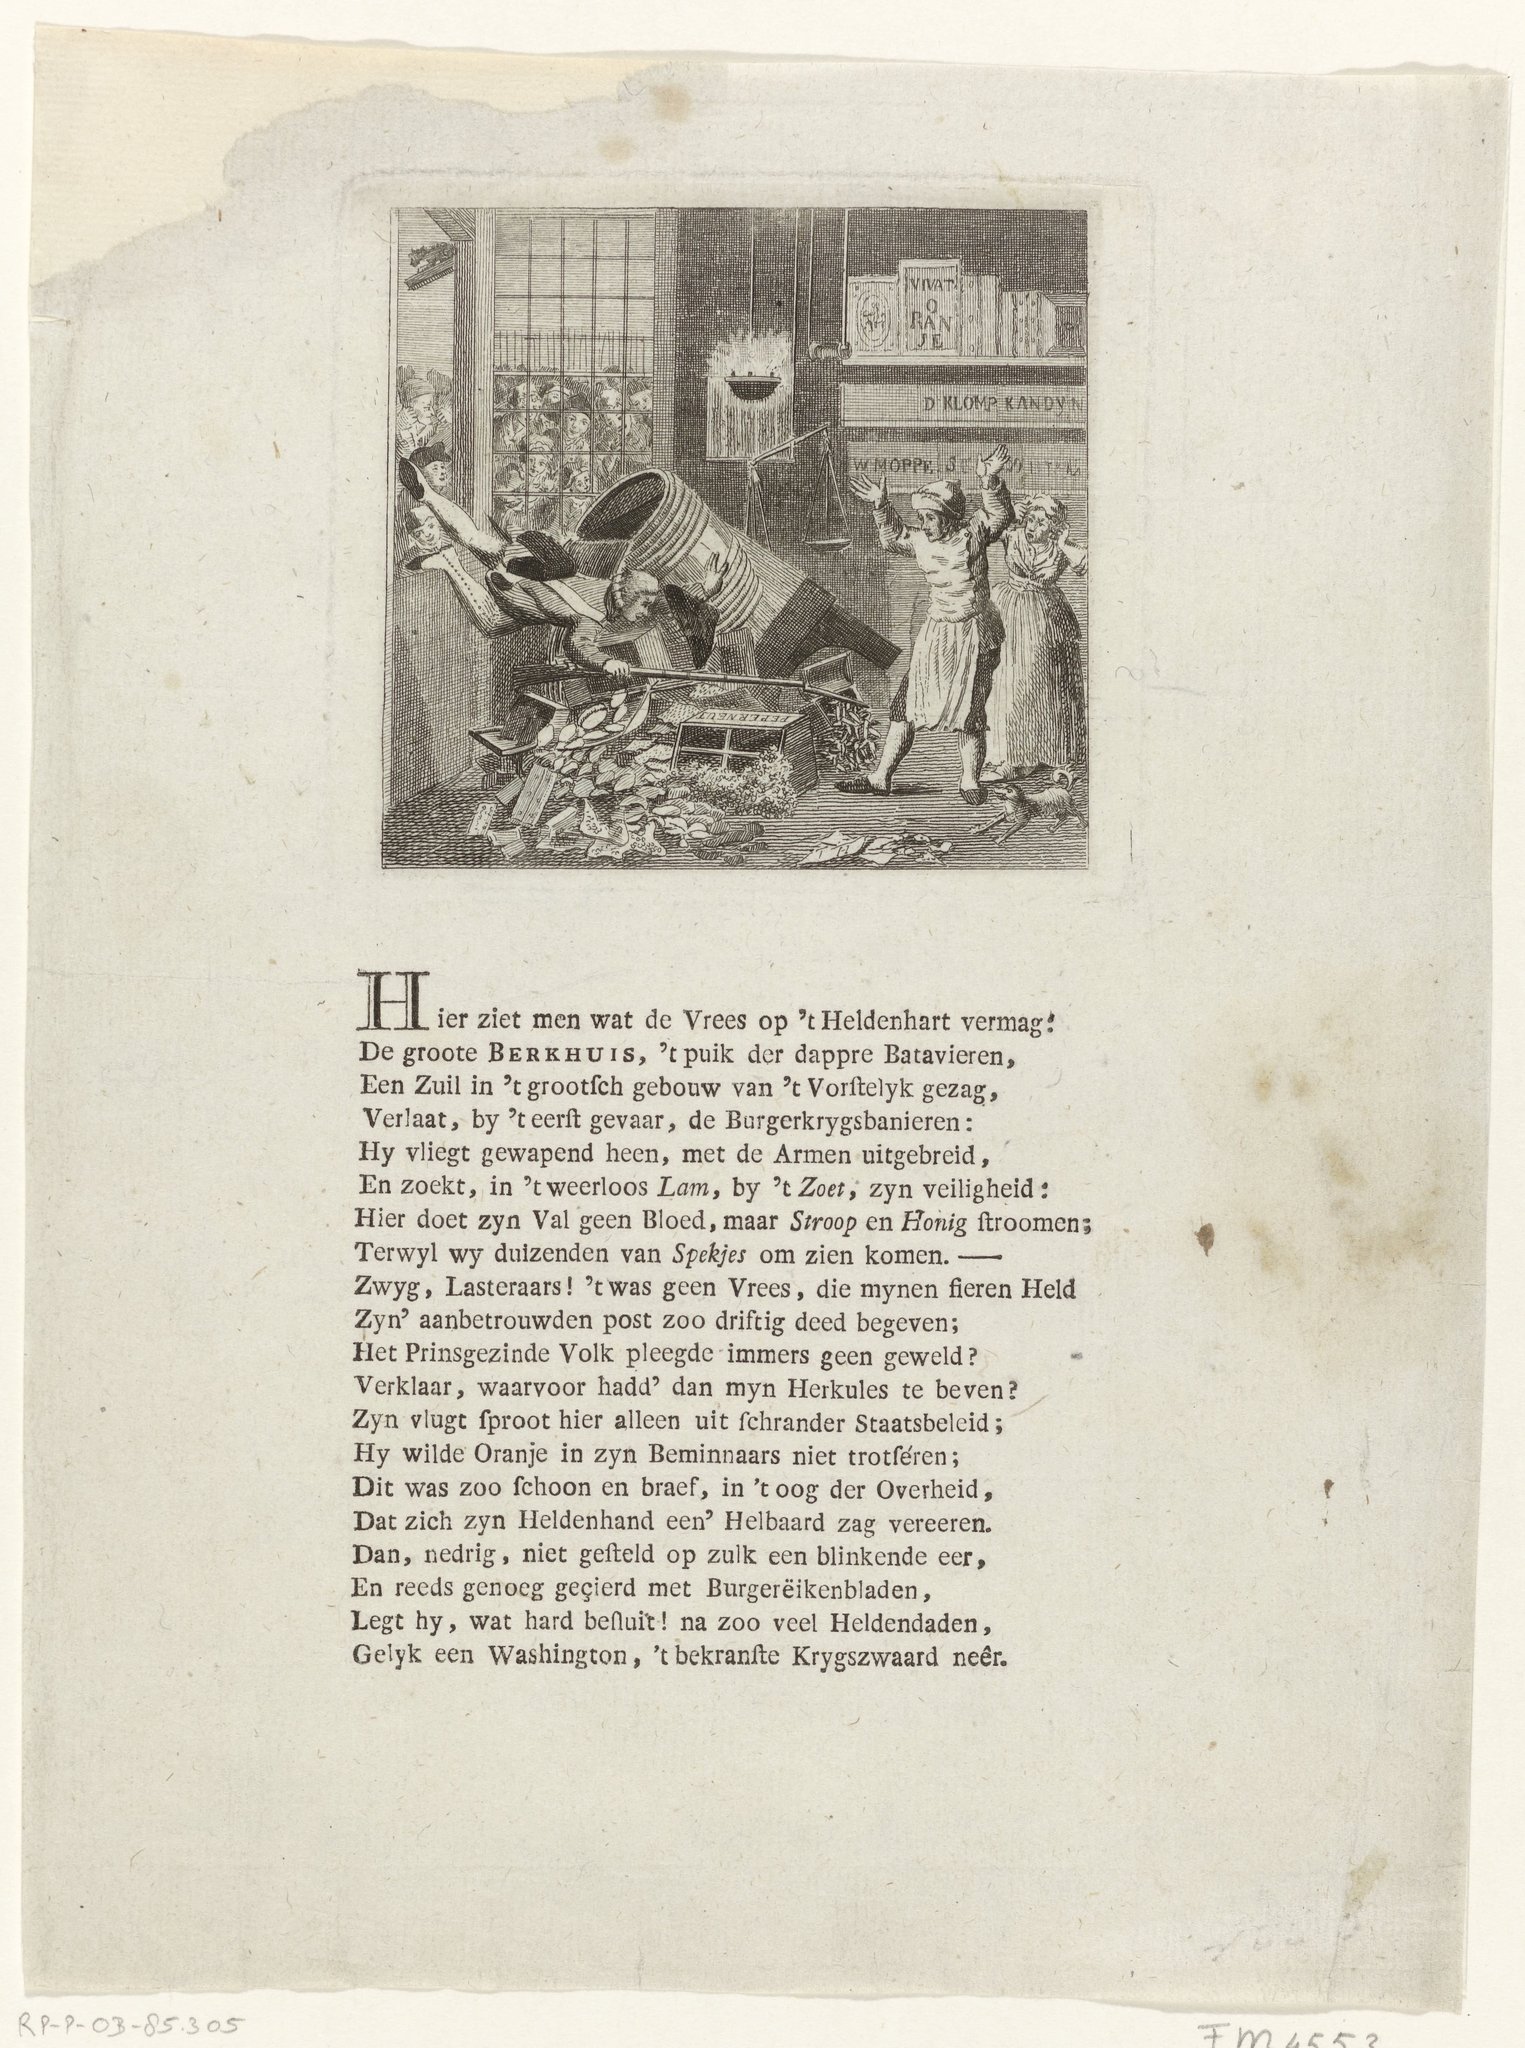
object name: cartoon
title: Spotprent op de adelborst Berghuis, 1784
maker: joannes hulstkamp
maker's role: print maker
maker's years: 1759-1786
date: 1784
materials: paper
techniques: etching, letterpress printing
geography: rotterdam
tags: rotterdam, patriots (1780-1795)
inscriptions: collector's mark: Lugt 2228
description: Spotprent op de adelborst Antonie Berghuis van de Negende Burgercompagnie te Rotterdam, die tijdens het geweld op 3 april 1784 in een suikerwinkel Het Lam vluchtte en in de stroop viel. Op met blad onder de plaat een vers van 20 regels.